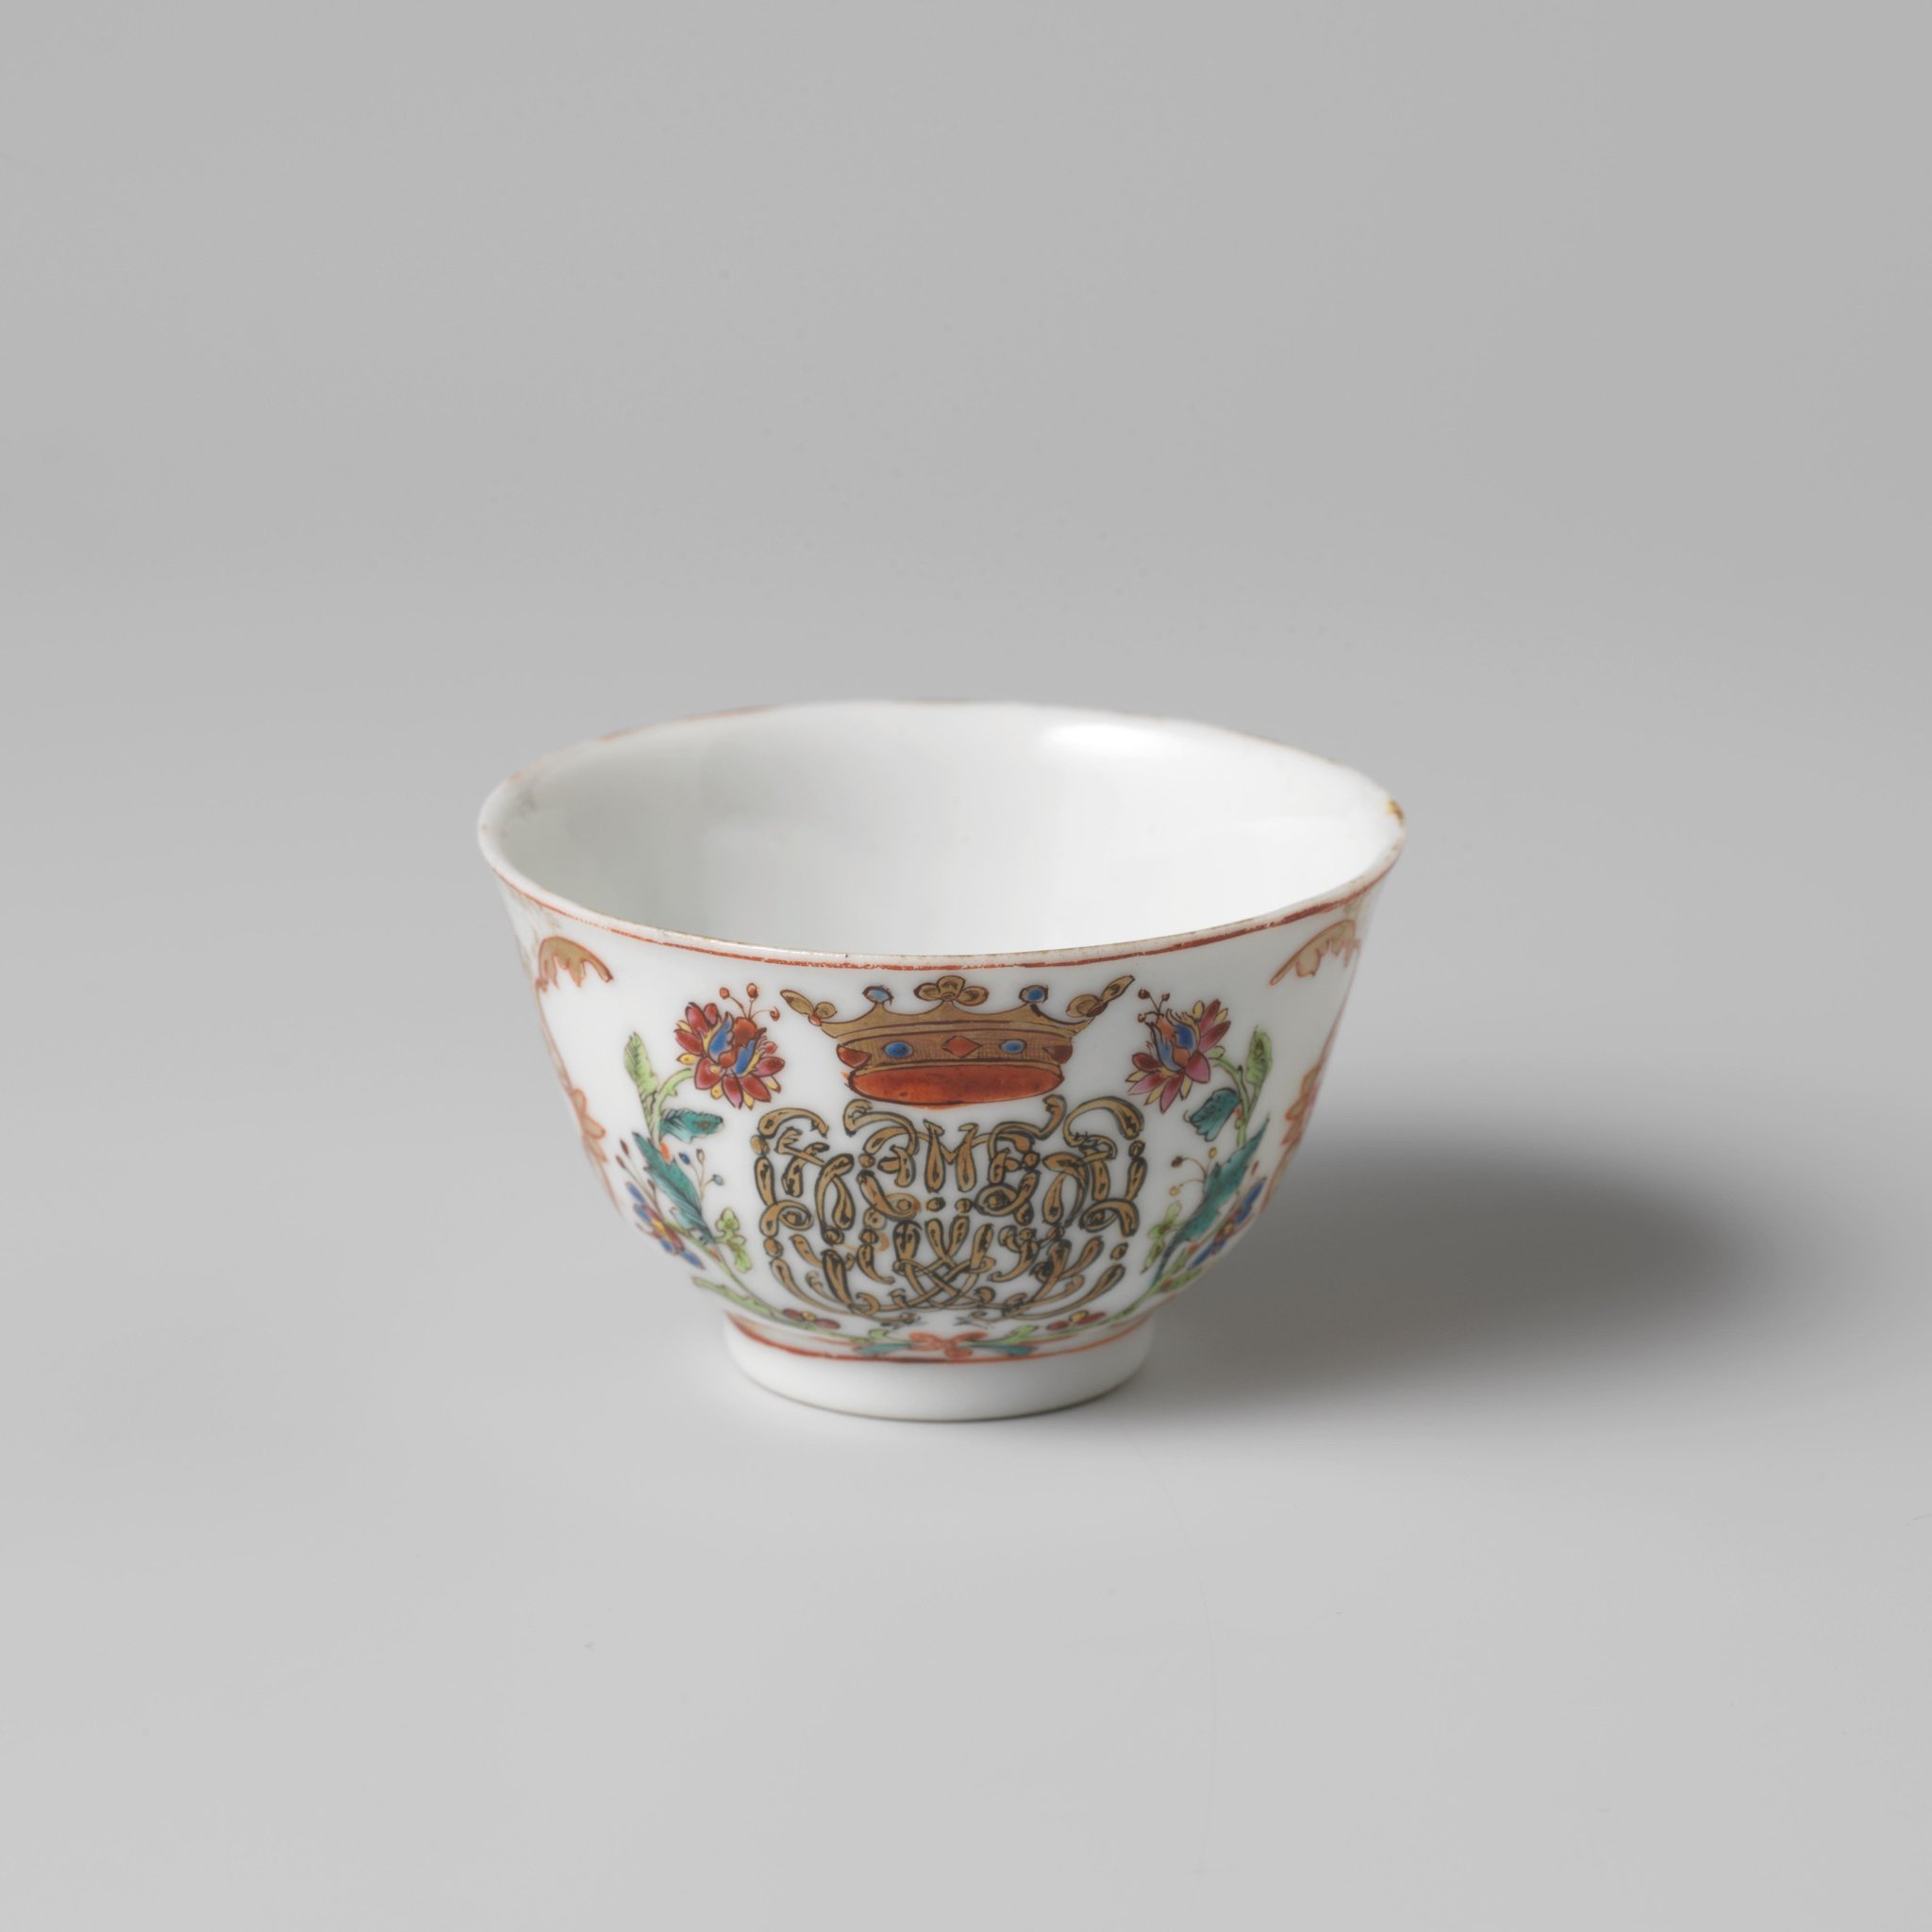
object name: cup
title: Bell-shaped cup with a crowned, illegible monogram surrounded by two flower sprays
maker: Anonymous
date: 1750-1774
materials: glaze, gold, paint, porcelain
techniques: firing, gilding, turning, vitrification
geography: china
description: Klokvormige kop van porselein, beschilderd op het glazuur in blauw, rood, roze, groen, geel, zwart en goud. Op de buitenwand tweemaal een gekroond, onleesbaar monogram omringd door twee bloemtakken; hiertussen bloemranken met daarin uitgespaard twee cartouches met een landschap en vier medaillons met planten. Europese voorstelling in emailkleuren.